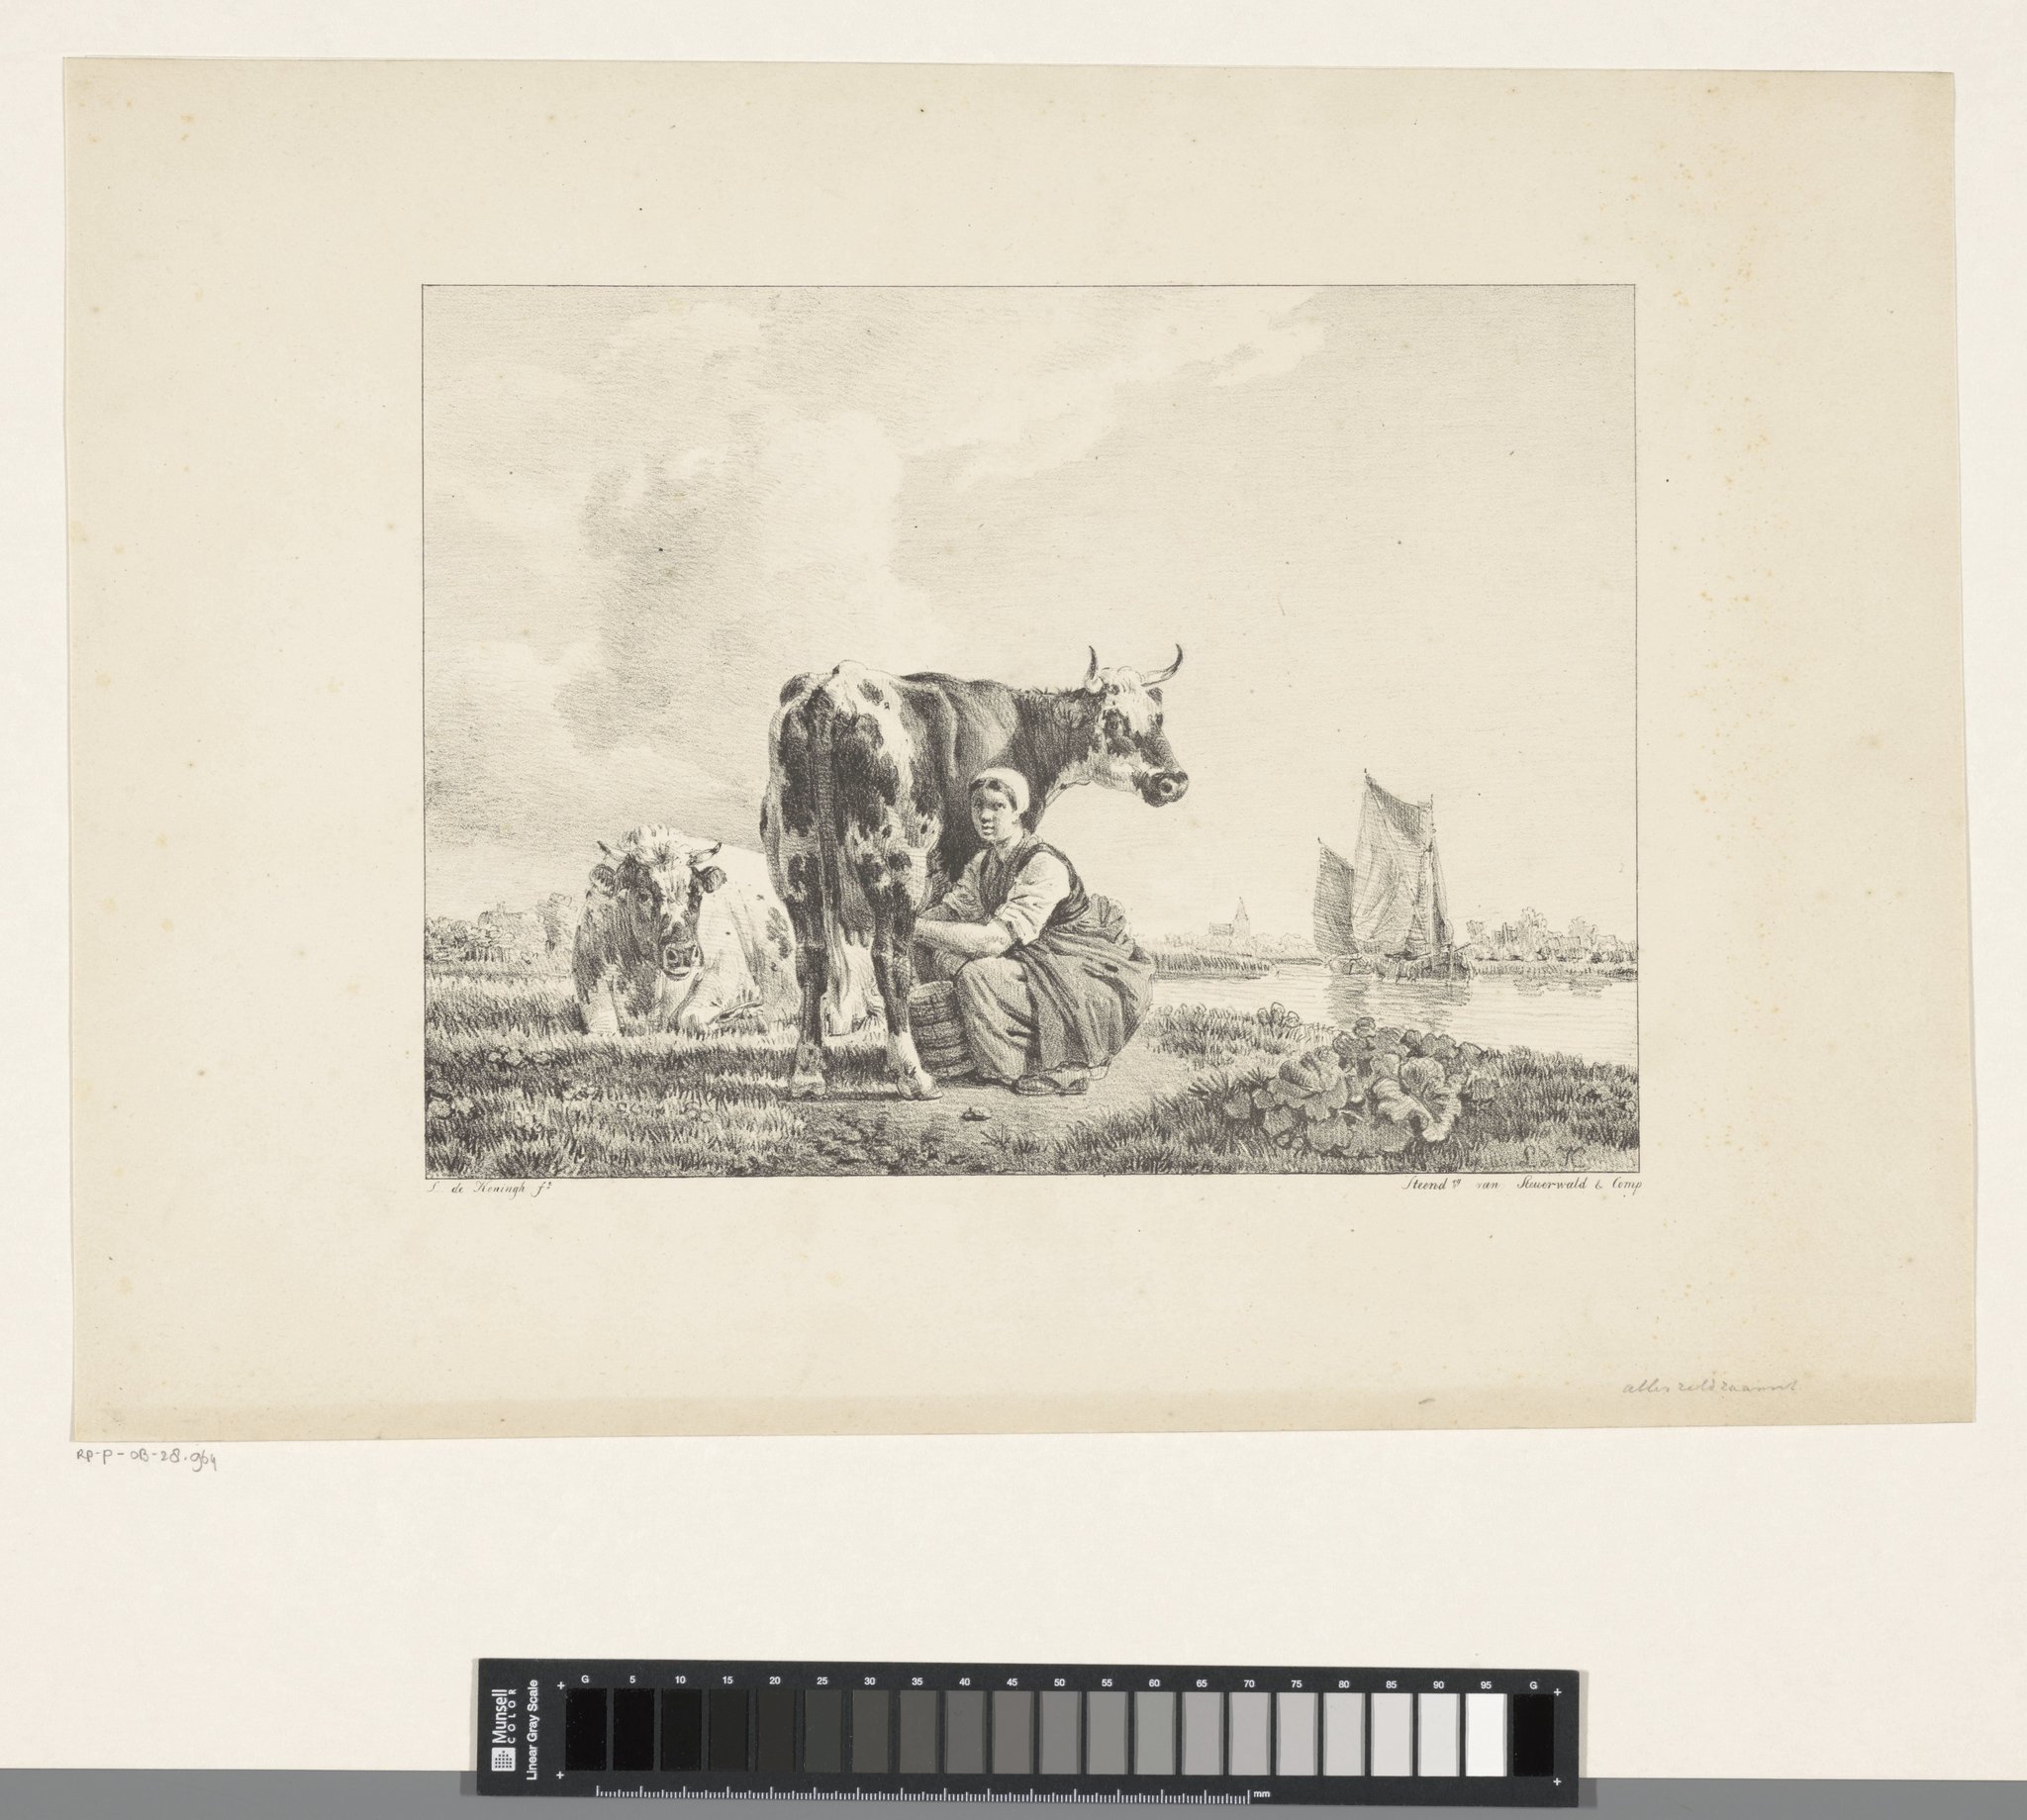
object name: print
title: Boerin melkt koe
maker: leendert de koningh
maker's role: draughtsman, print maker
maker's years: 1777-1849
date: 1826-1833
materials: paper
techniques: lithograph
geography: dordrecht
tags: cow, sailing-ship, sailing-boat, river, milking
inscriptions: collector's mark: Lugt 2228, inscription: ‘allerzeldzaamst’